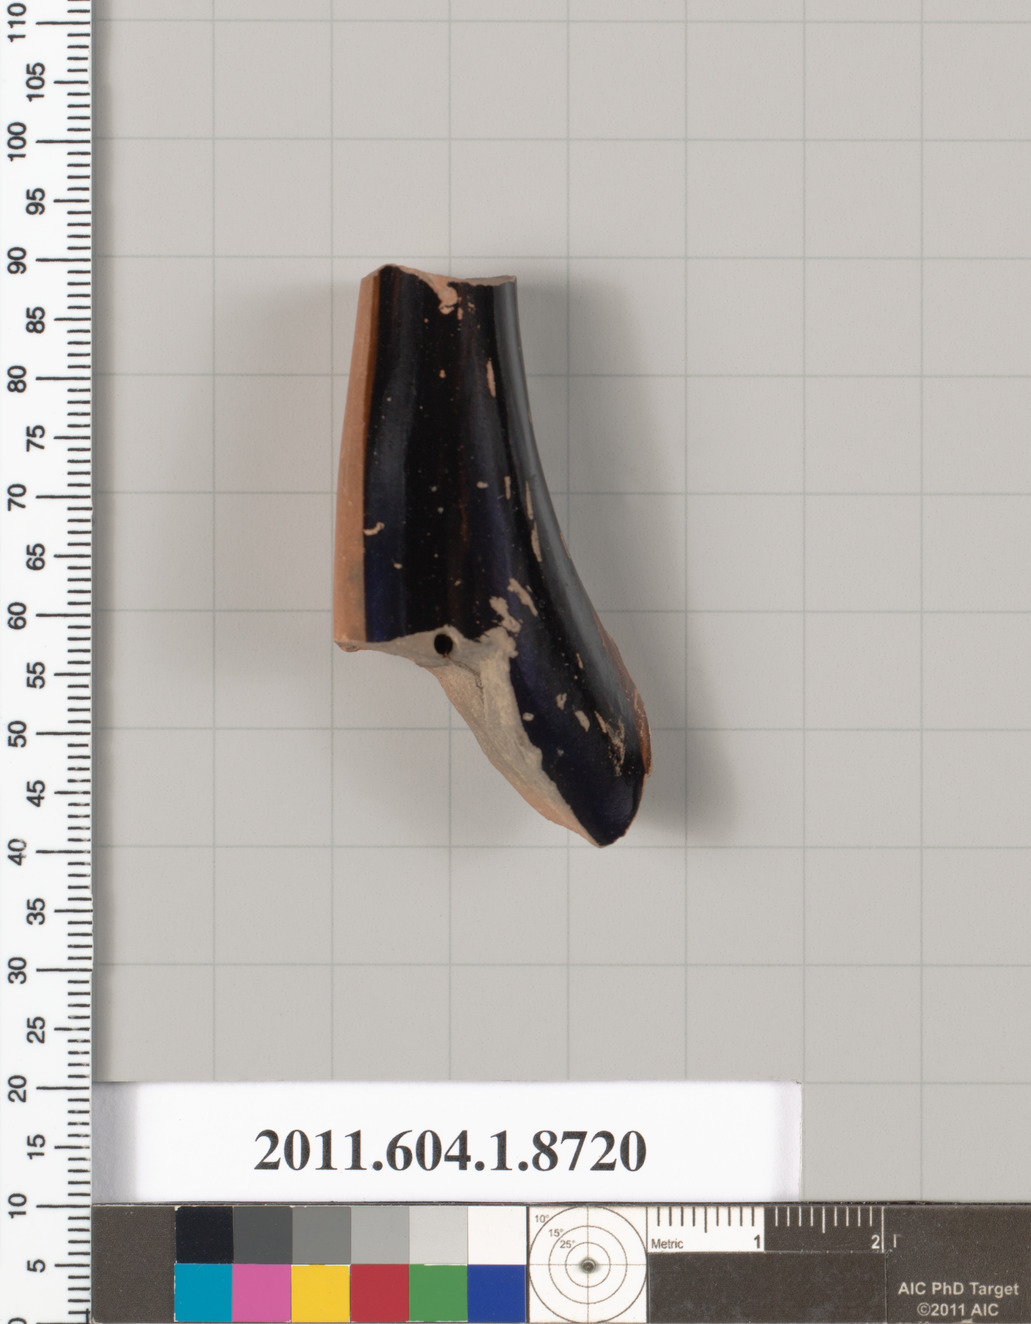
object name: kylix fragment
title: Terracotta fragment of a kylix (drinking cup)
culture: greek, attic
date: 490-480 BCE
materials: terracotta